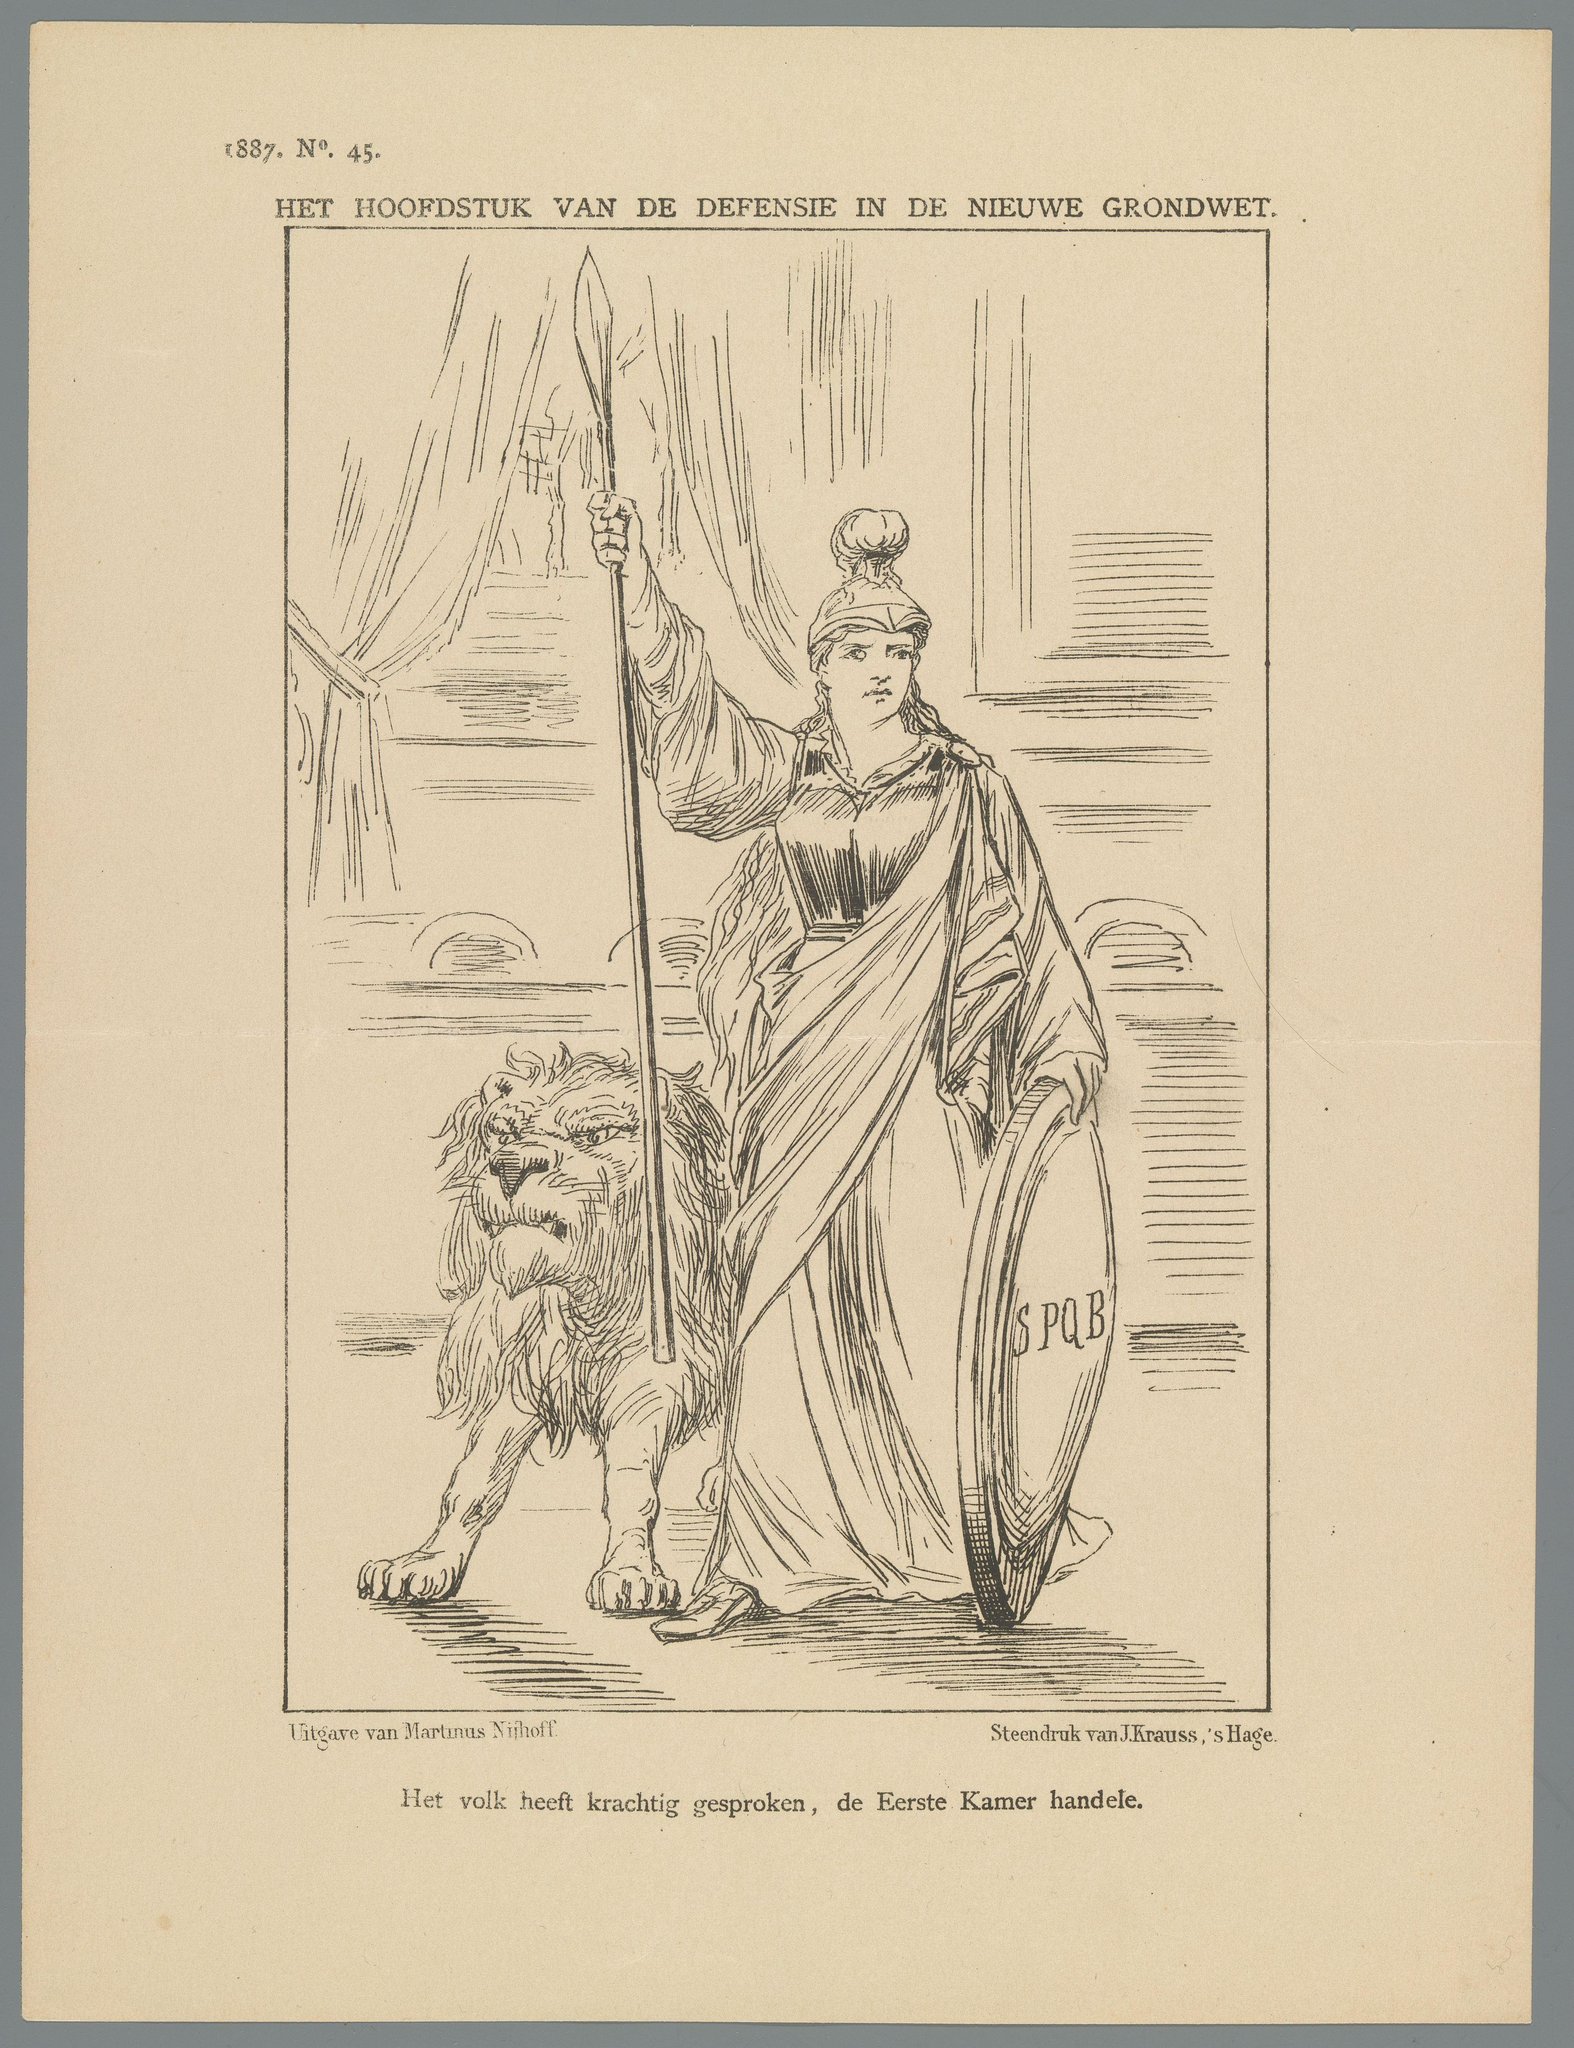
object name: print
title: Het hoofdstuk van de defensie in de nieuwe grondwet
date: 1887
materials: paper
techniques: lithograph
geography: the hague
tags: personifications of countries, nations, states, districts, etc.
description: Spotprent over het hoofdstuk over de defensie in de grondwetsherziening. Plaat verschenen bij het weekblad De Nederlandsche Spectator, nr. 45, 1887.